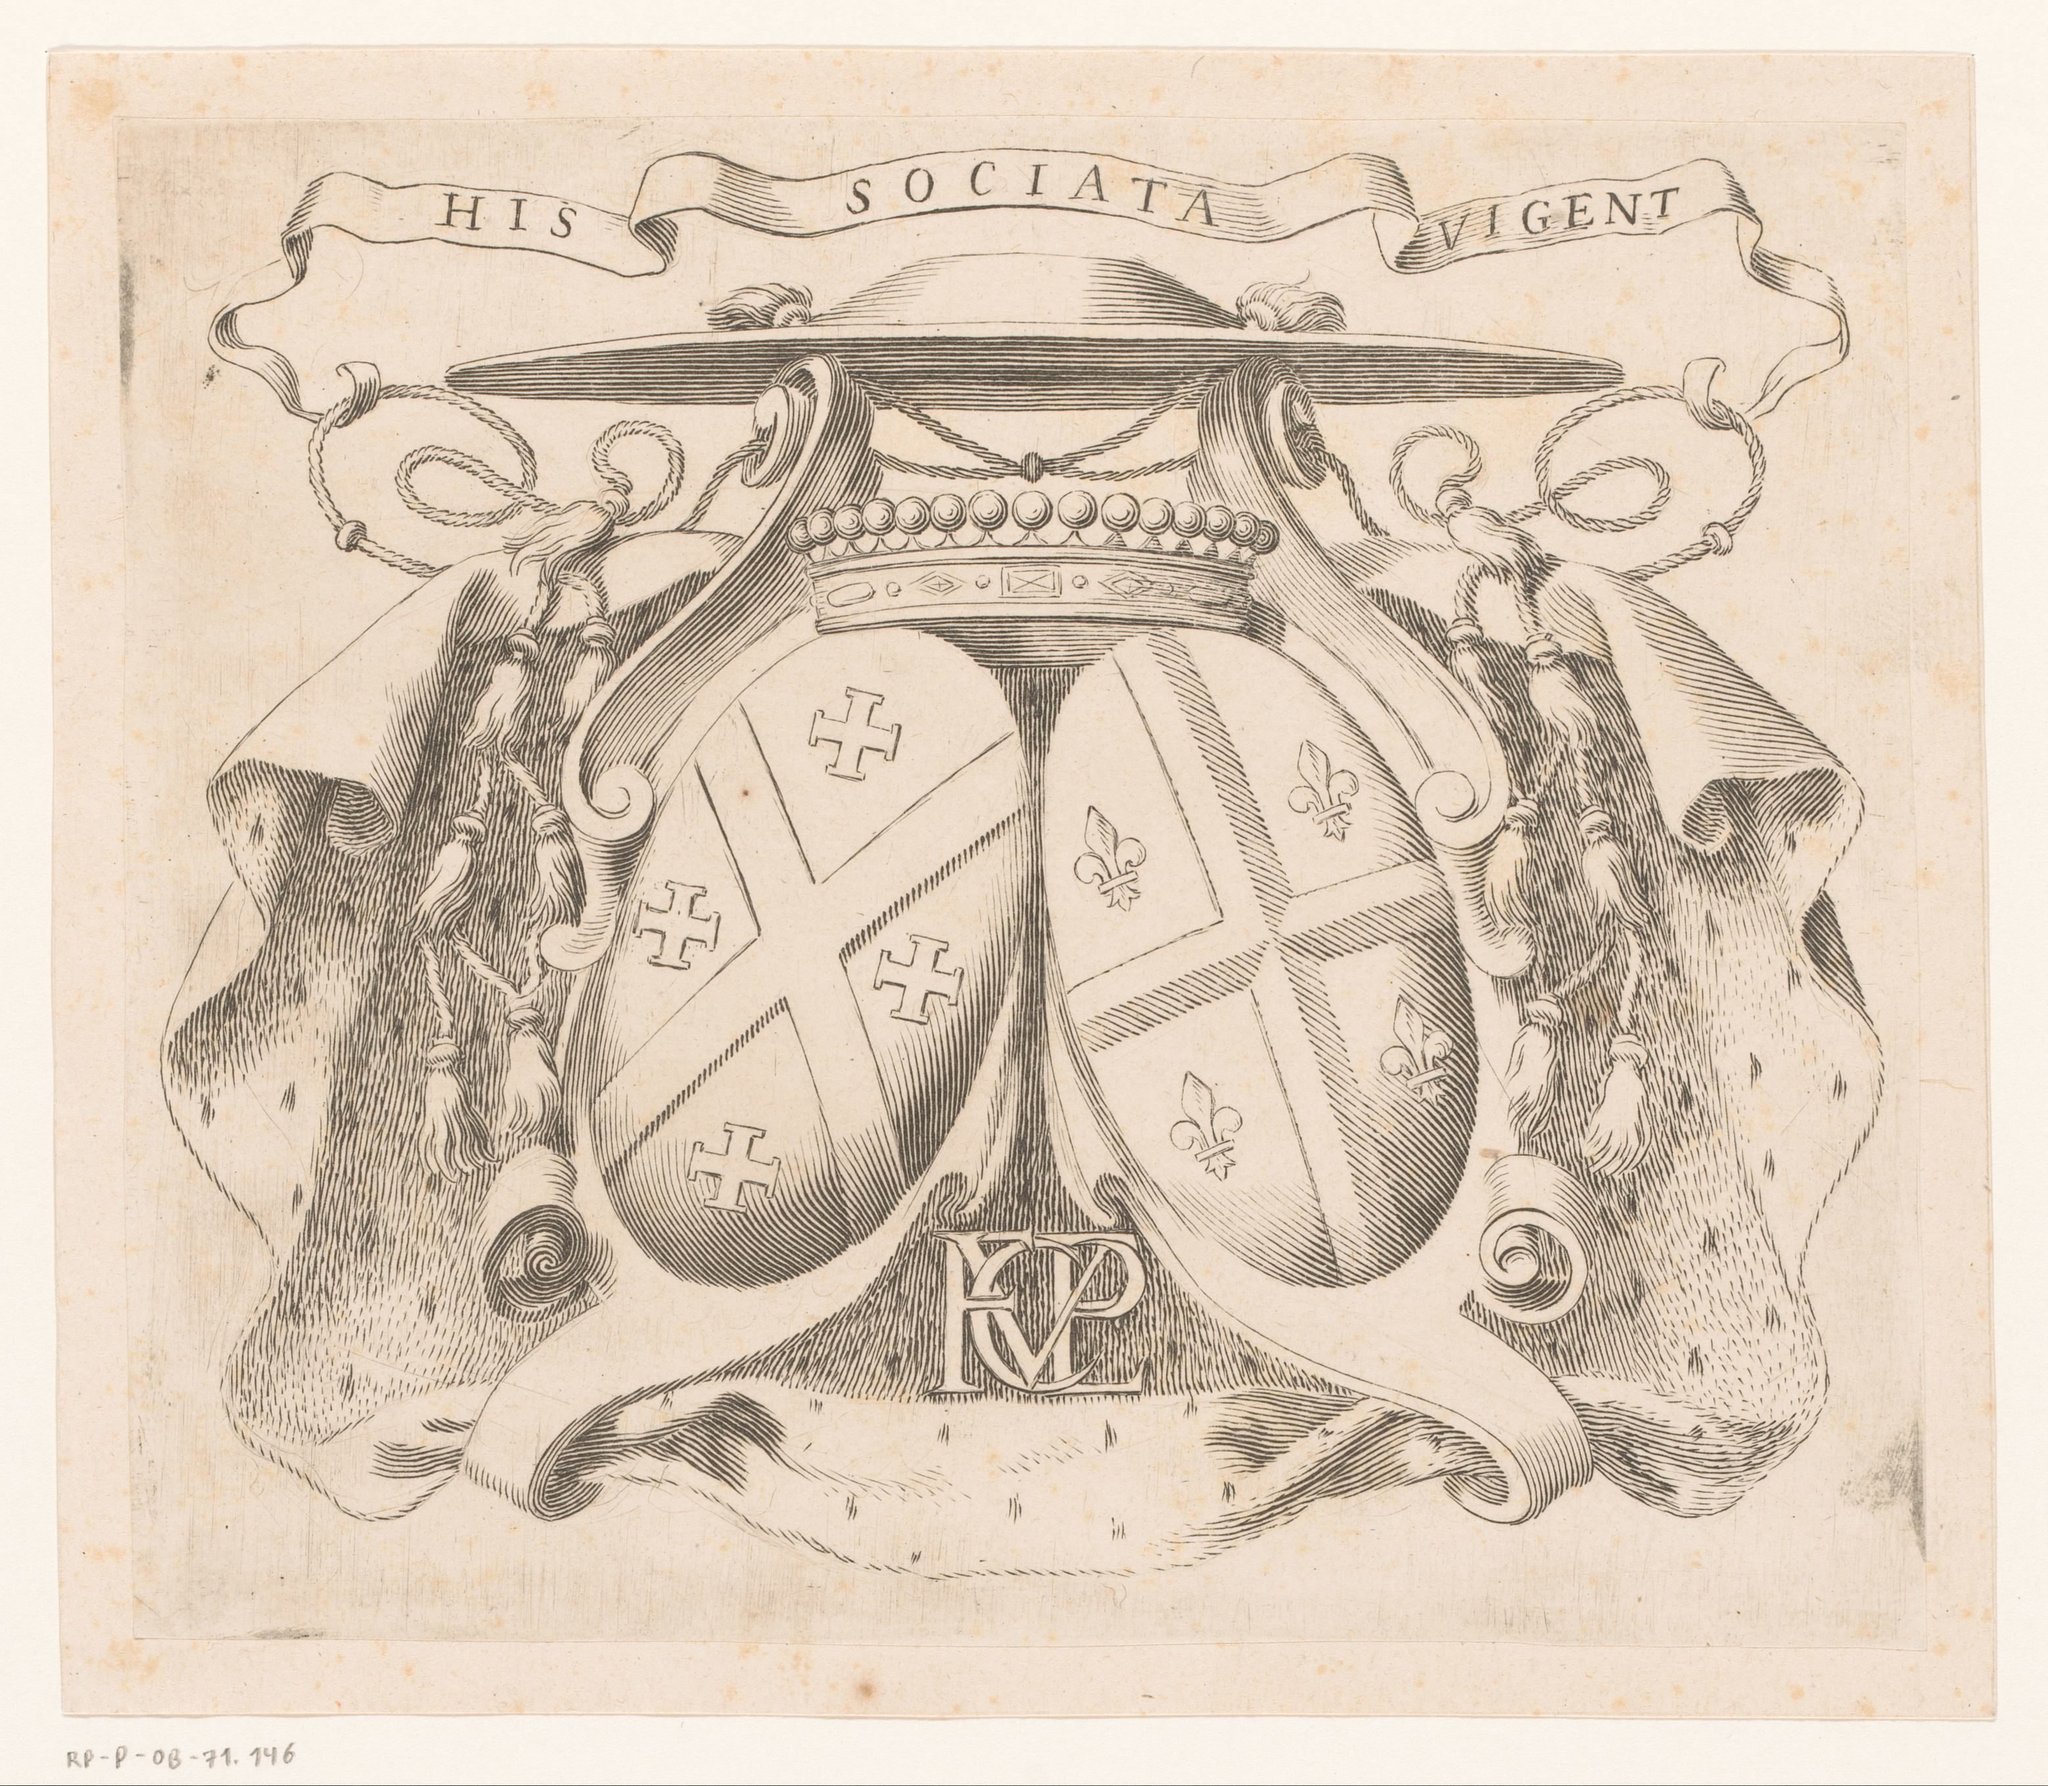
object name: print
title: Wapenschild van Félix Vialar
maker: claude mellan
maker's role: draughtsman, print maker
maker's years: 1598-1688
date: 1608-1688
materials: paper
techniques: engraving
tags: clergyman, armorial bearing, heraldry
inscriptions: collector's mark: Lugt 240